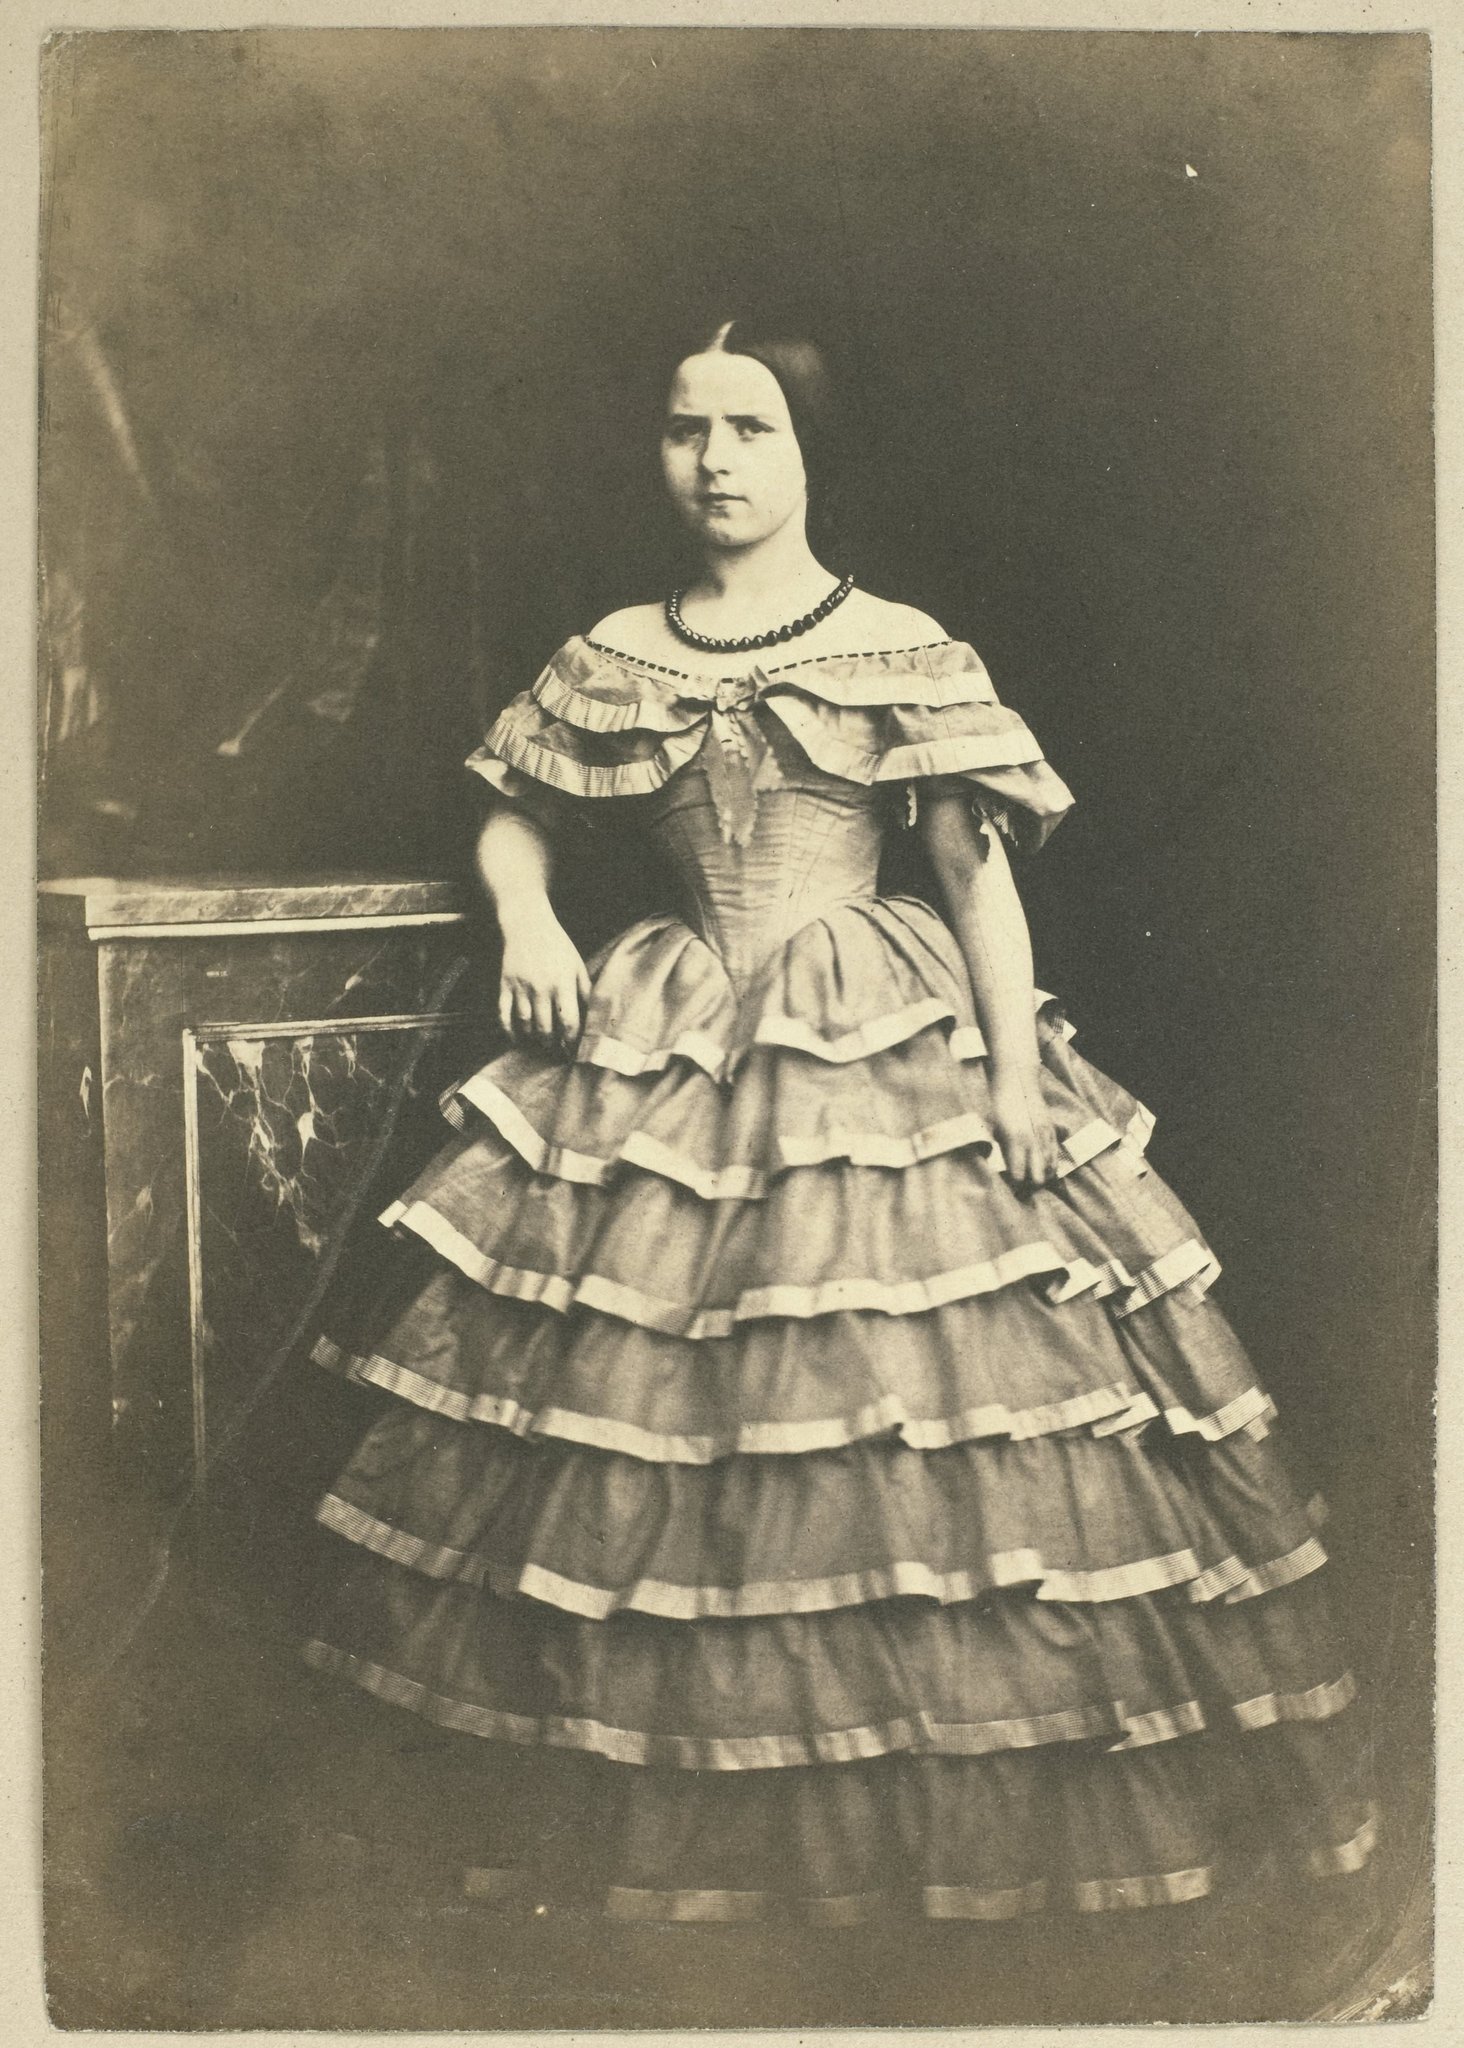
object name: photograph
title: Portret van een jonge vrouw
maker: eduard isaac asser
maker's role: amateurfotograaf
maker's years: 1809-1894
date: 1853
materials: cardboard, paper, photographic support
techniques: salted paper print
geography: amsterdam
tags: historical persons - bb - woman, netherlands